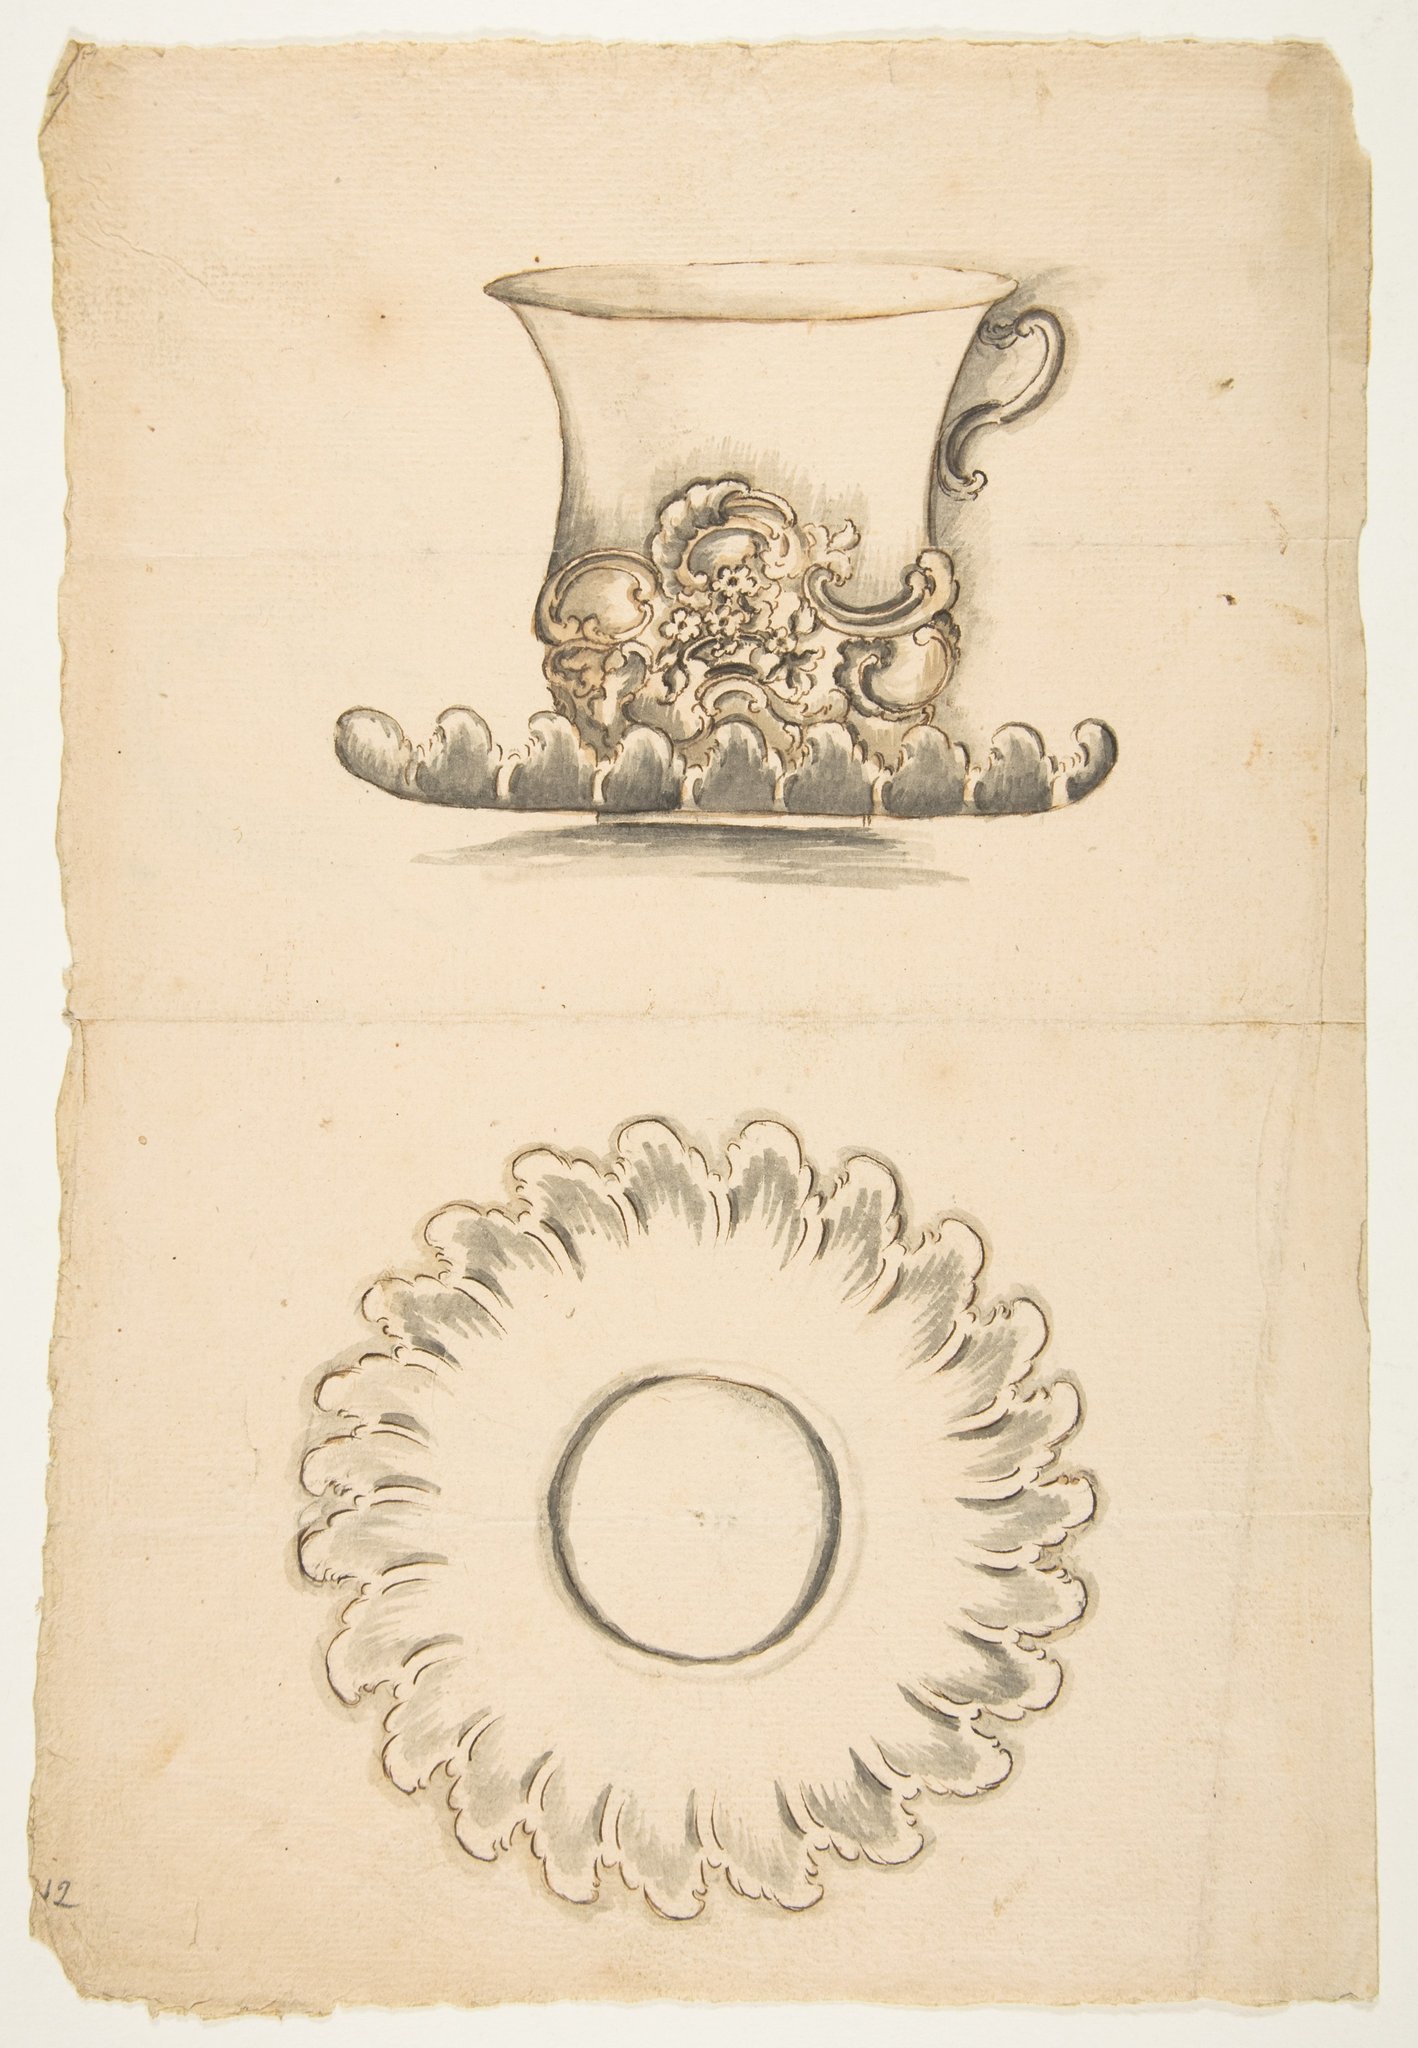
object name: drawing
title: Design for a cup and saucer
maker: anonymous, french, 19th century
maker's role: artist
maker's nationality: french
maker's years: 1800-1900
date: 1801-1900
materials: ink, paper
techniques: pen, wash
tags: cups,saucers